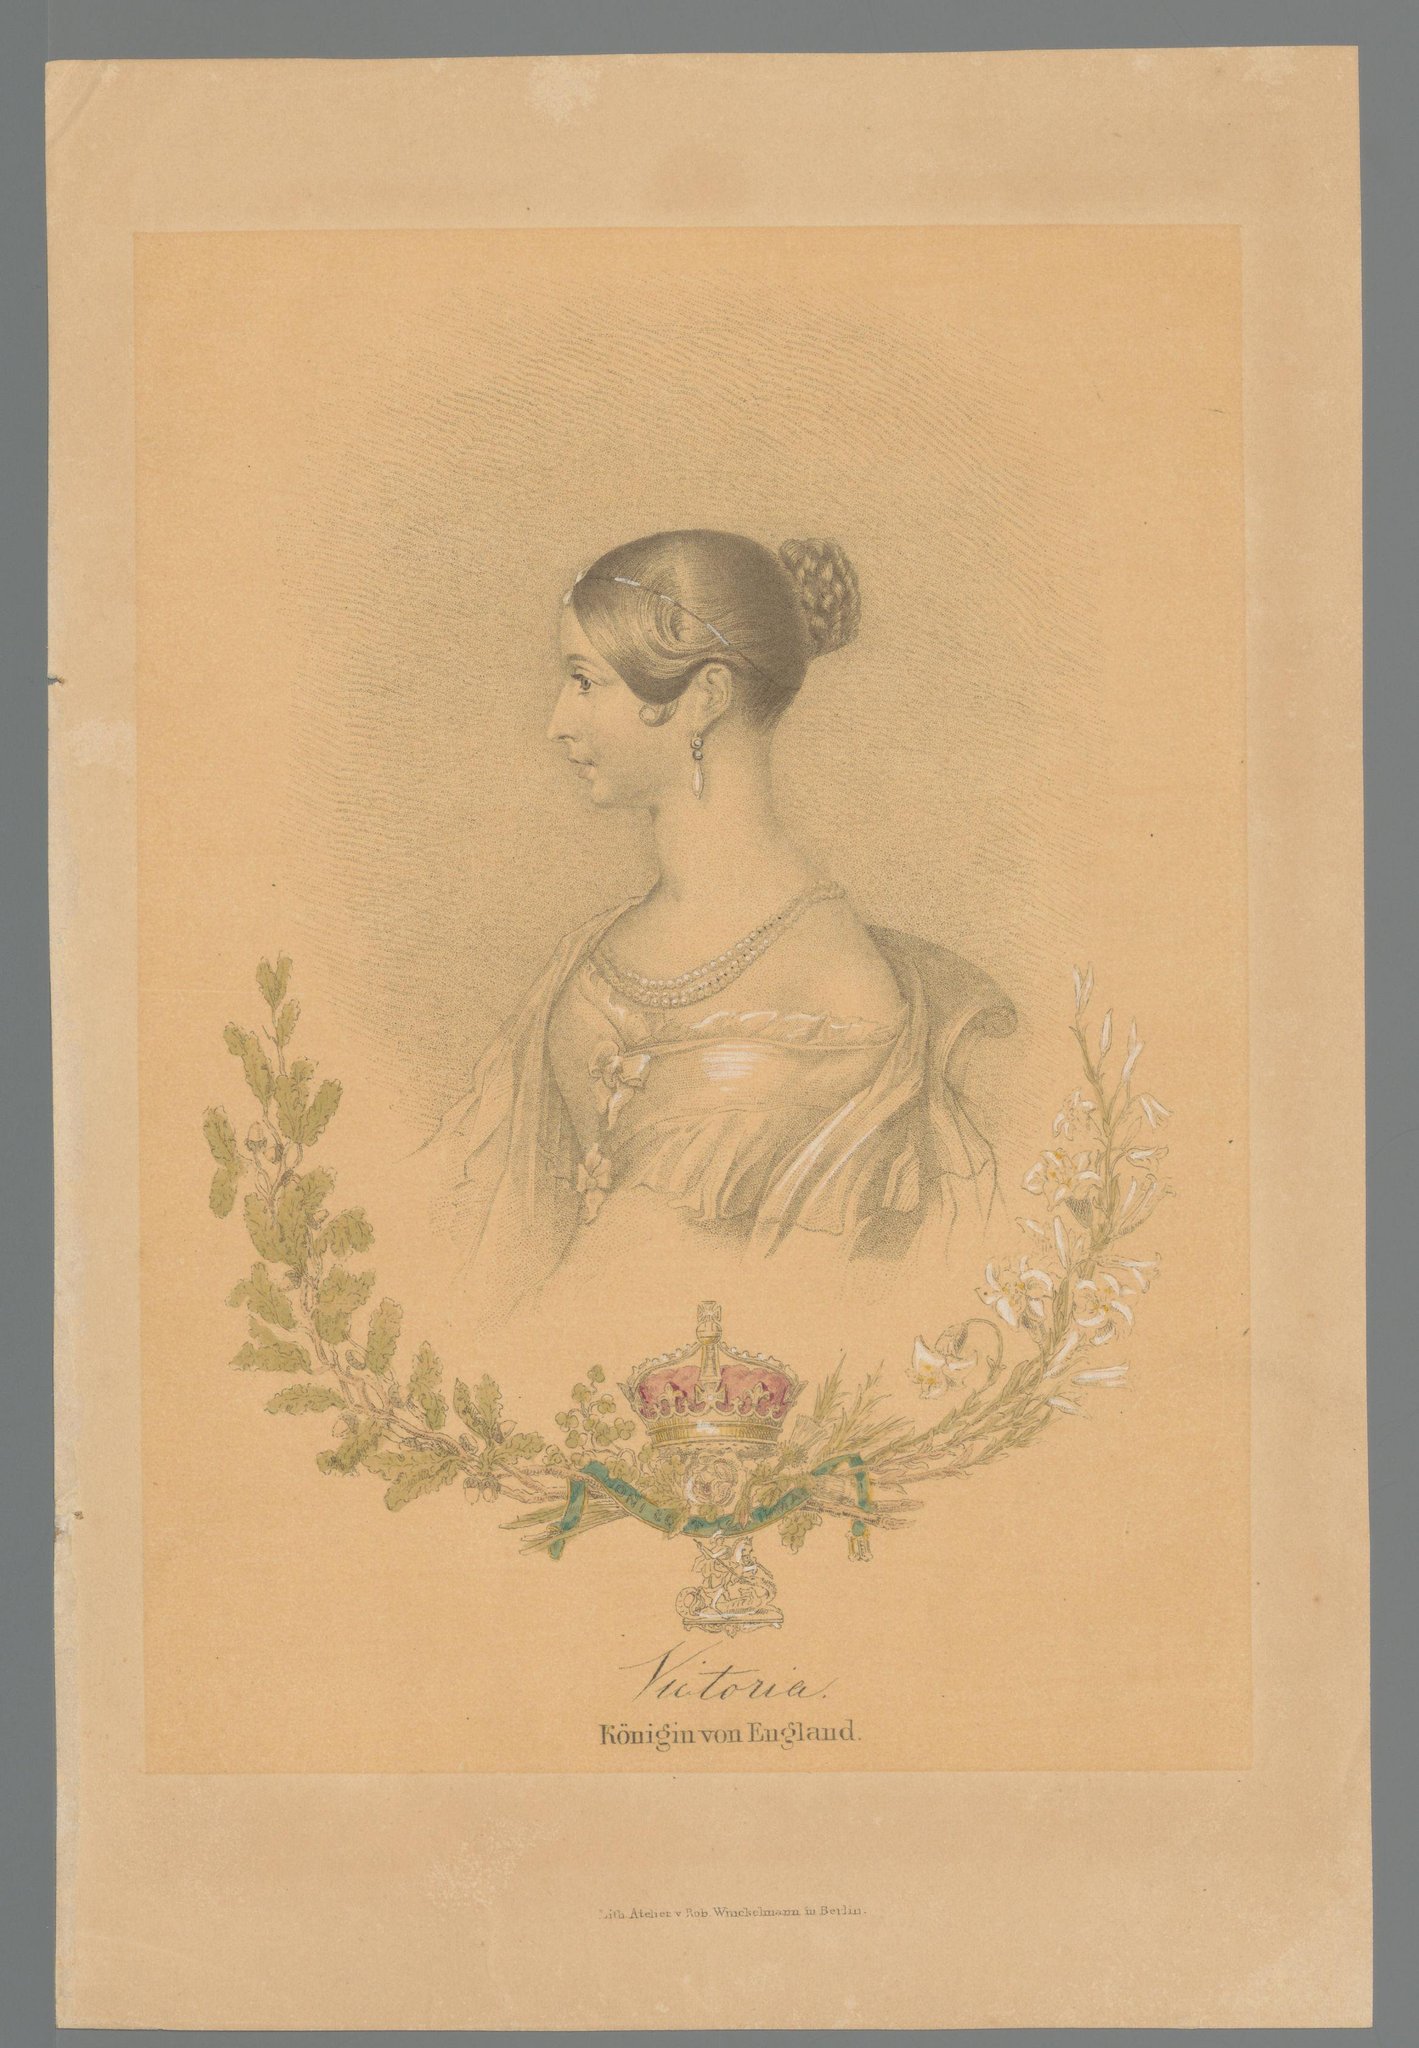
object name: print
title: Victoria, Königin von England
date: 1830-1890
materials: paper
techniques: hand coloring, lithograph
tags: victoria (koningin van het verenigd koninkrijk en keizerin van india), adult woman, historical persons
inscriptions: collector's mark: Lugt 2228